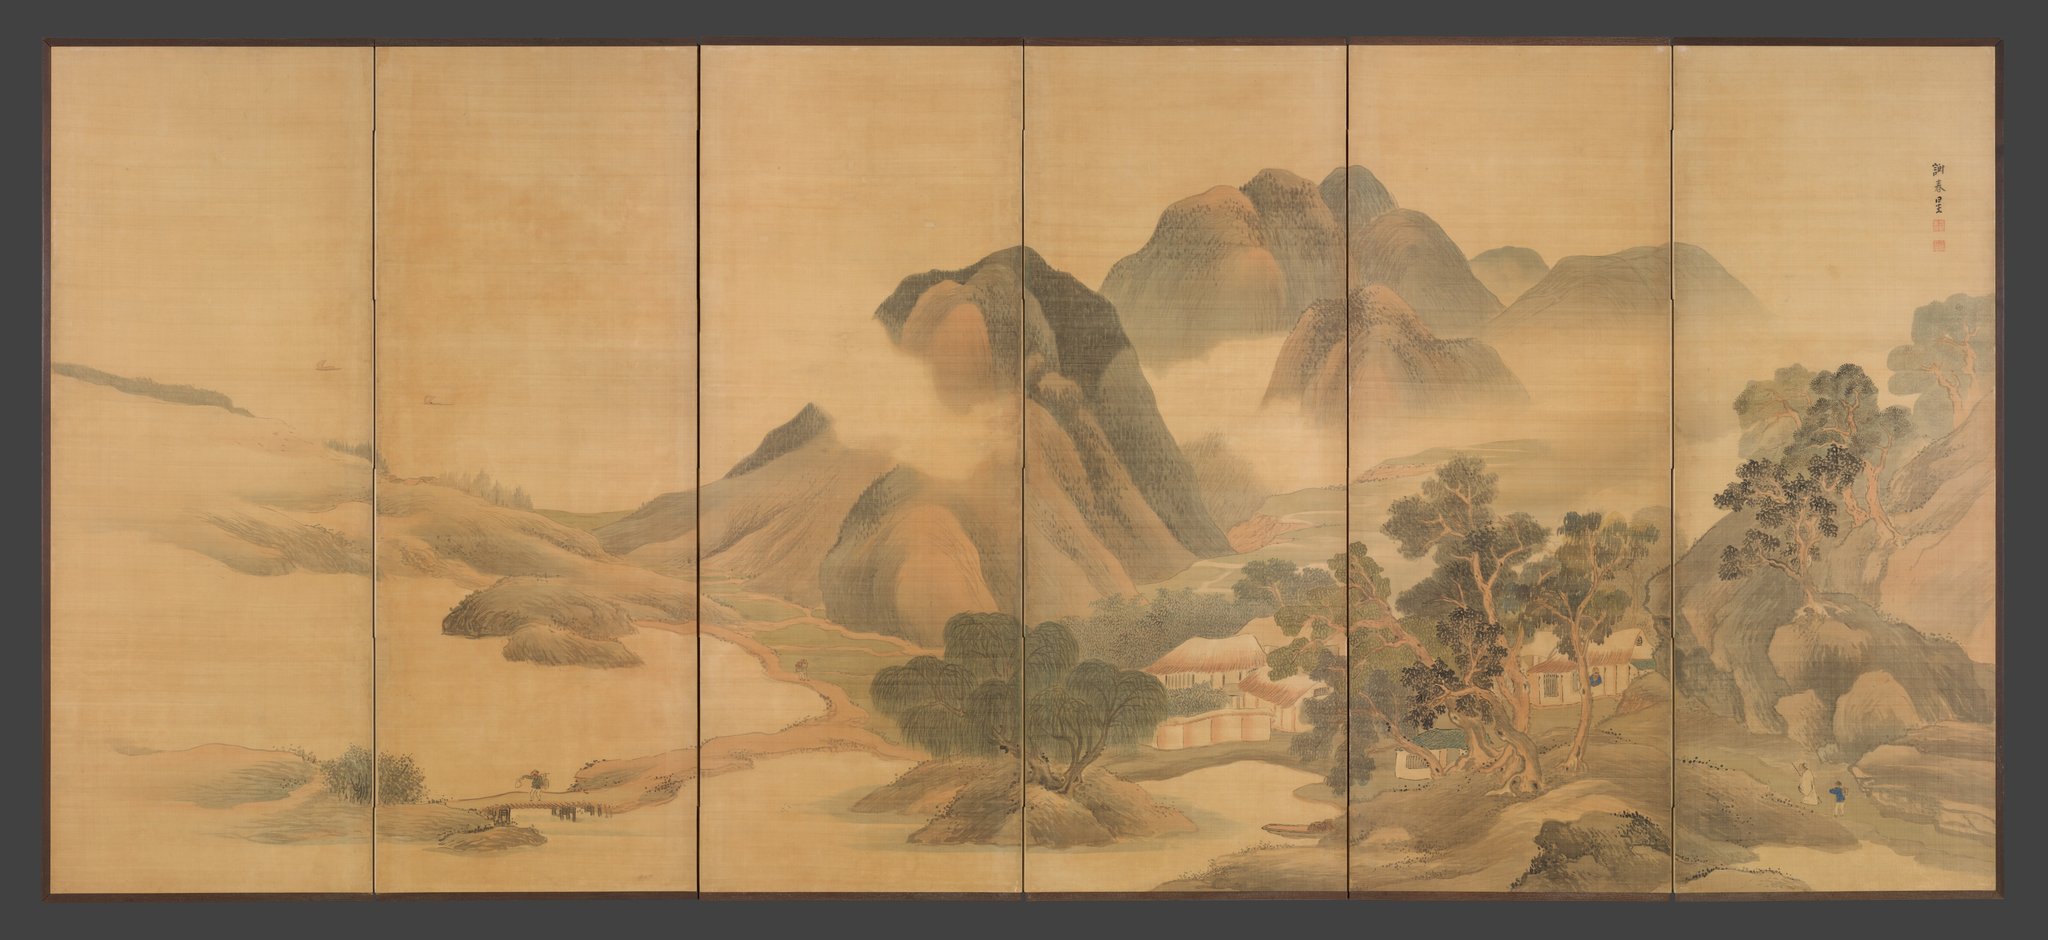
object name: screen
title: Travels through Mountains and Fields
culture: japanese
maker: yosa buson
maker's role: artist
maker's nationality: japanese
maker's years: 1716-1783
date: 1765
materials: ink, panel, silk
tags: mountains